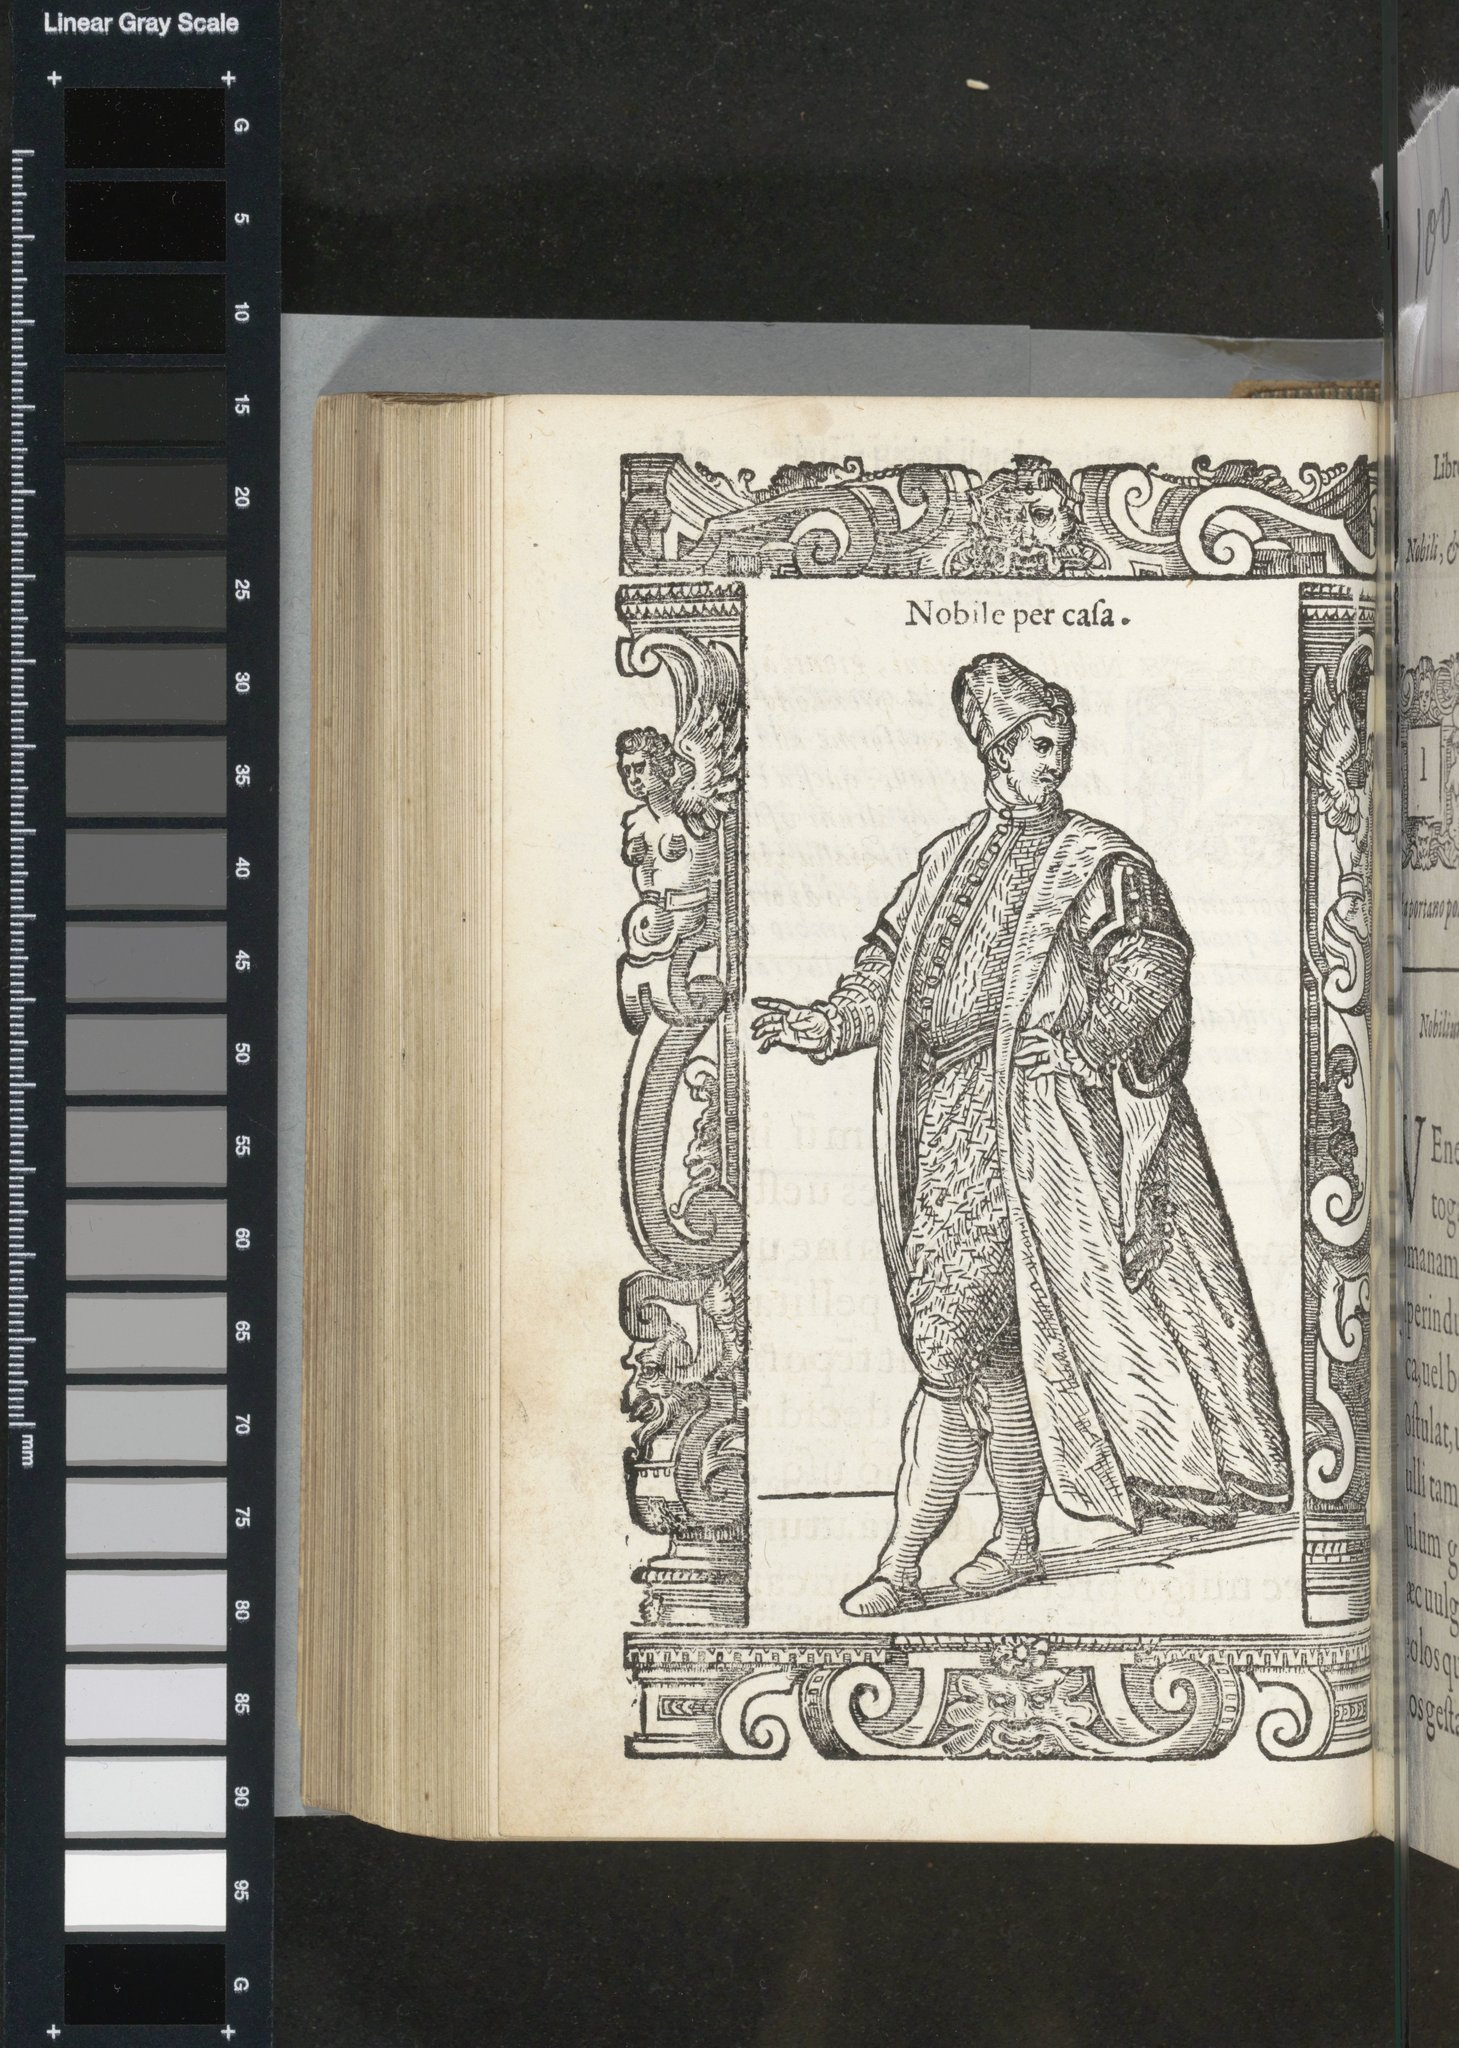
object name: costume print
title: Habiti antichi, et moderni di tutto il mondo..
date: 1598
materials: paper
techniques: woodcut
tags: fashion plates